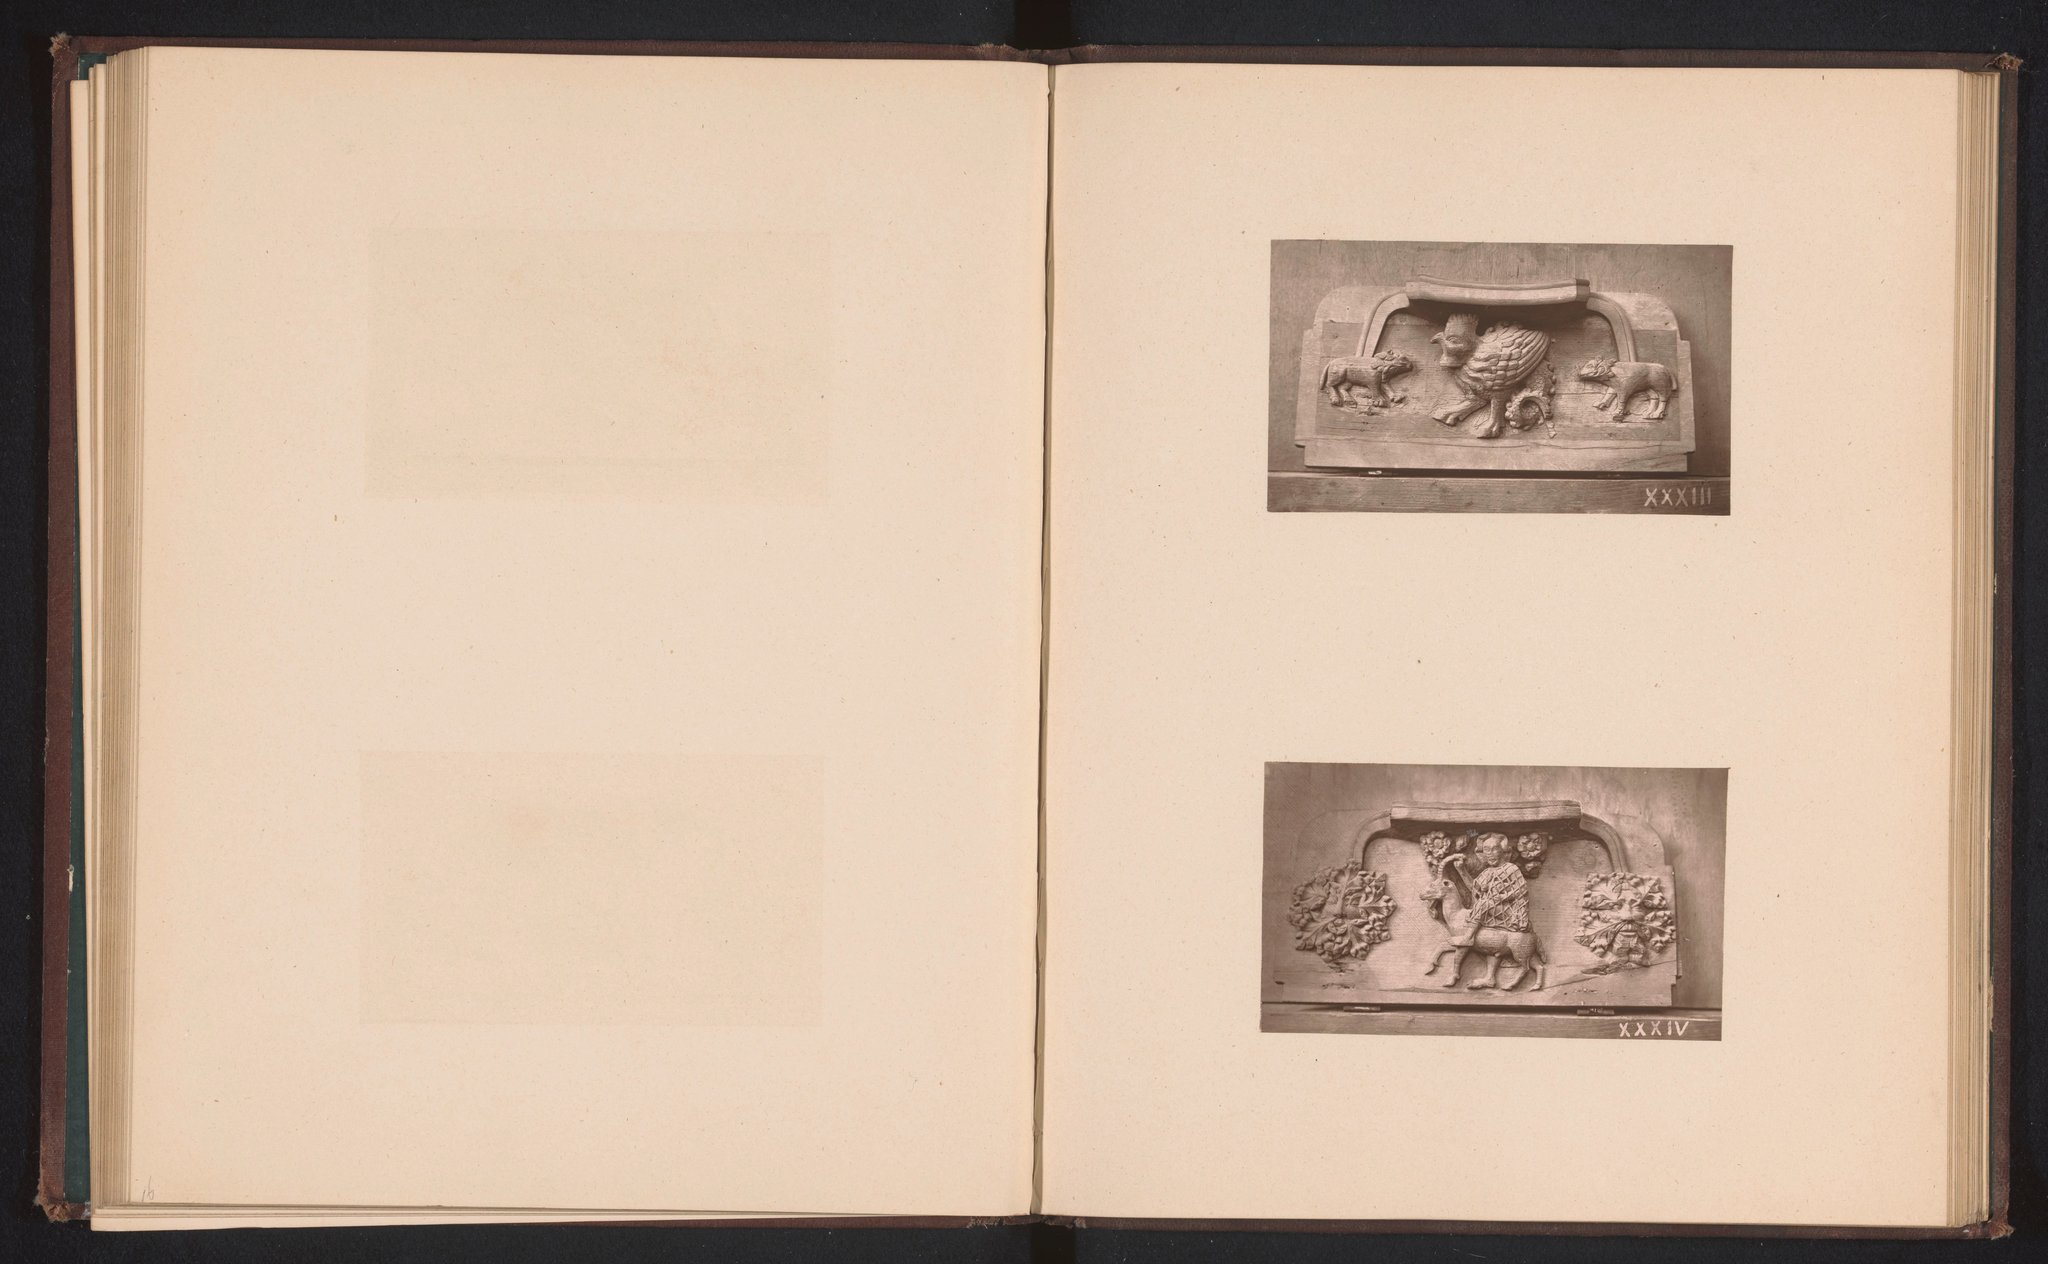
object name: photomechanical print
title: Twee houtsnijwerken in de Kathedraal van Worcester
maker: Anonymous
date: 1863-1873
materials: paper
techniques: woodburytype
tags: carving ~ applied arts, interior of church, goat, basilisk (cock with posterior of snake)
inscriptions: number: ‘XXXIII (...) XXXIV’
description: Boven een basilisk tussen (vermoedelijk) twee wolven, onder een man op een geit tussen twee gestileerde bladmotieven.